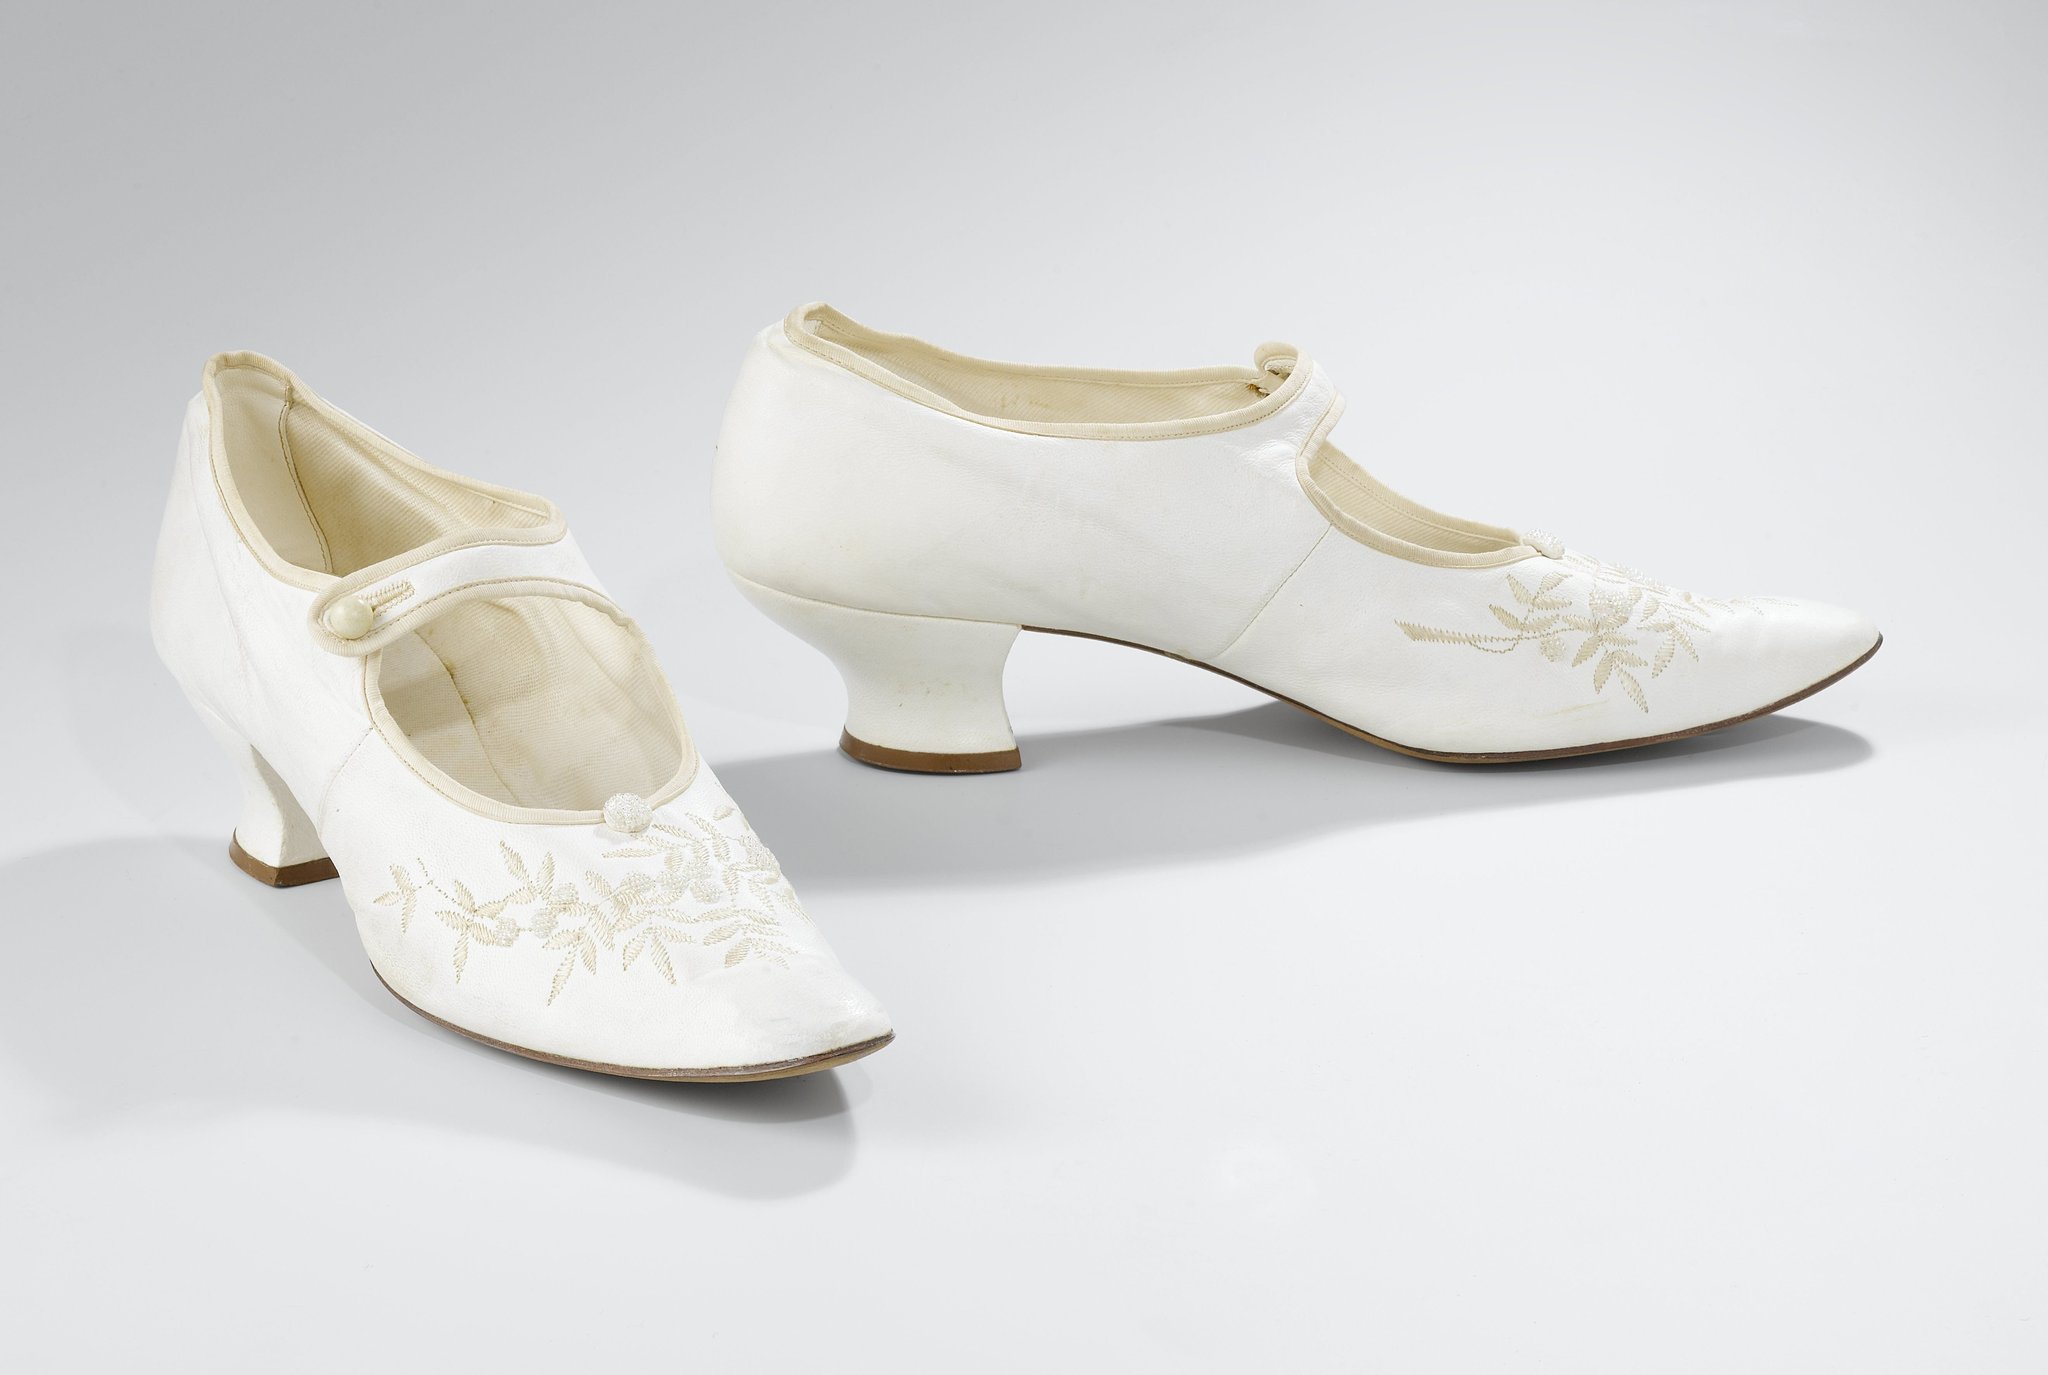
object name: damesschoen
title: Bruidsschoen van wit glacé-leer, op het voorblad met geborduurde crème takjes en witkralen bloemen; afgeronde spitse neus, Pompadourhak met leer overtrokken, wreefbandje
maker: Anonymous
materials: glazing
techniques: embroidered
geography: netherlands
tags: amsterdam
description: Bruidsschoentjes van wit glacé-leer, horend bij bruidsjapon. Het glacé-leer is op het voorblad geborduurd met crême takjes en wit kralen bloempjes. Afgeronde zeer spitse neus, riempje over de wreef met knoopsluiting en Pompadour-hakje met leer overtrokken.